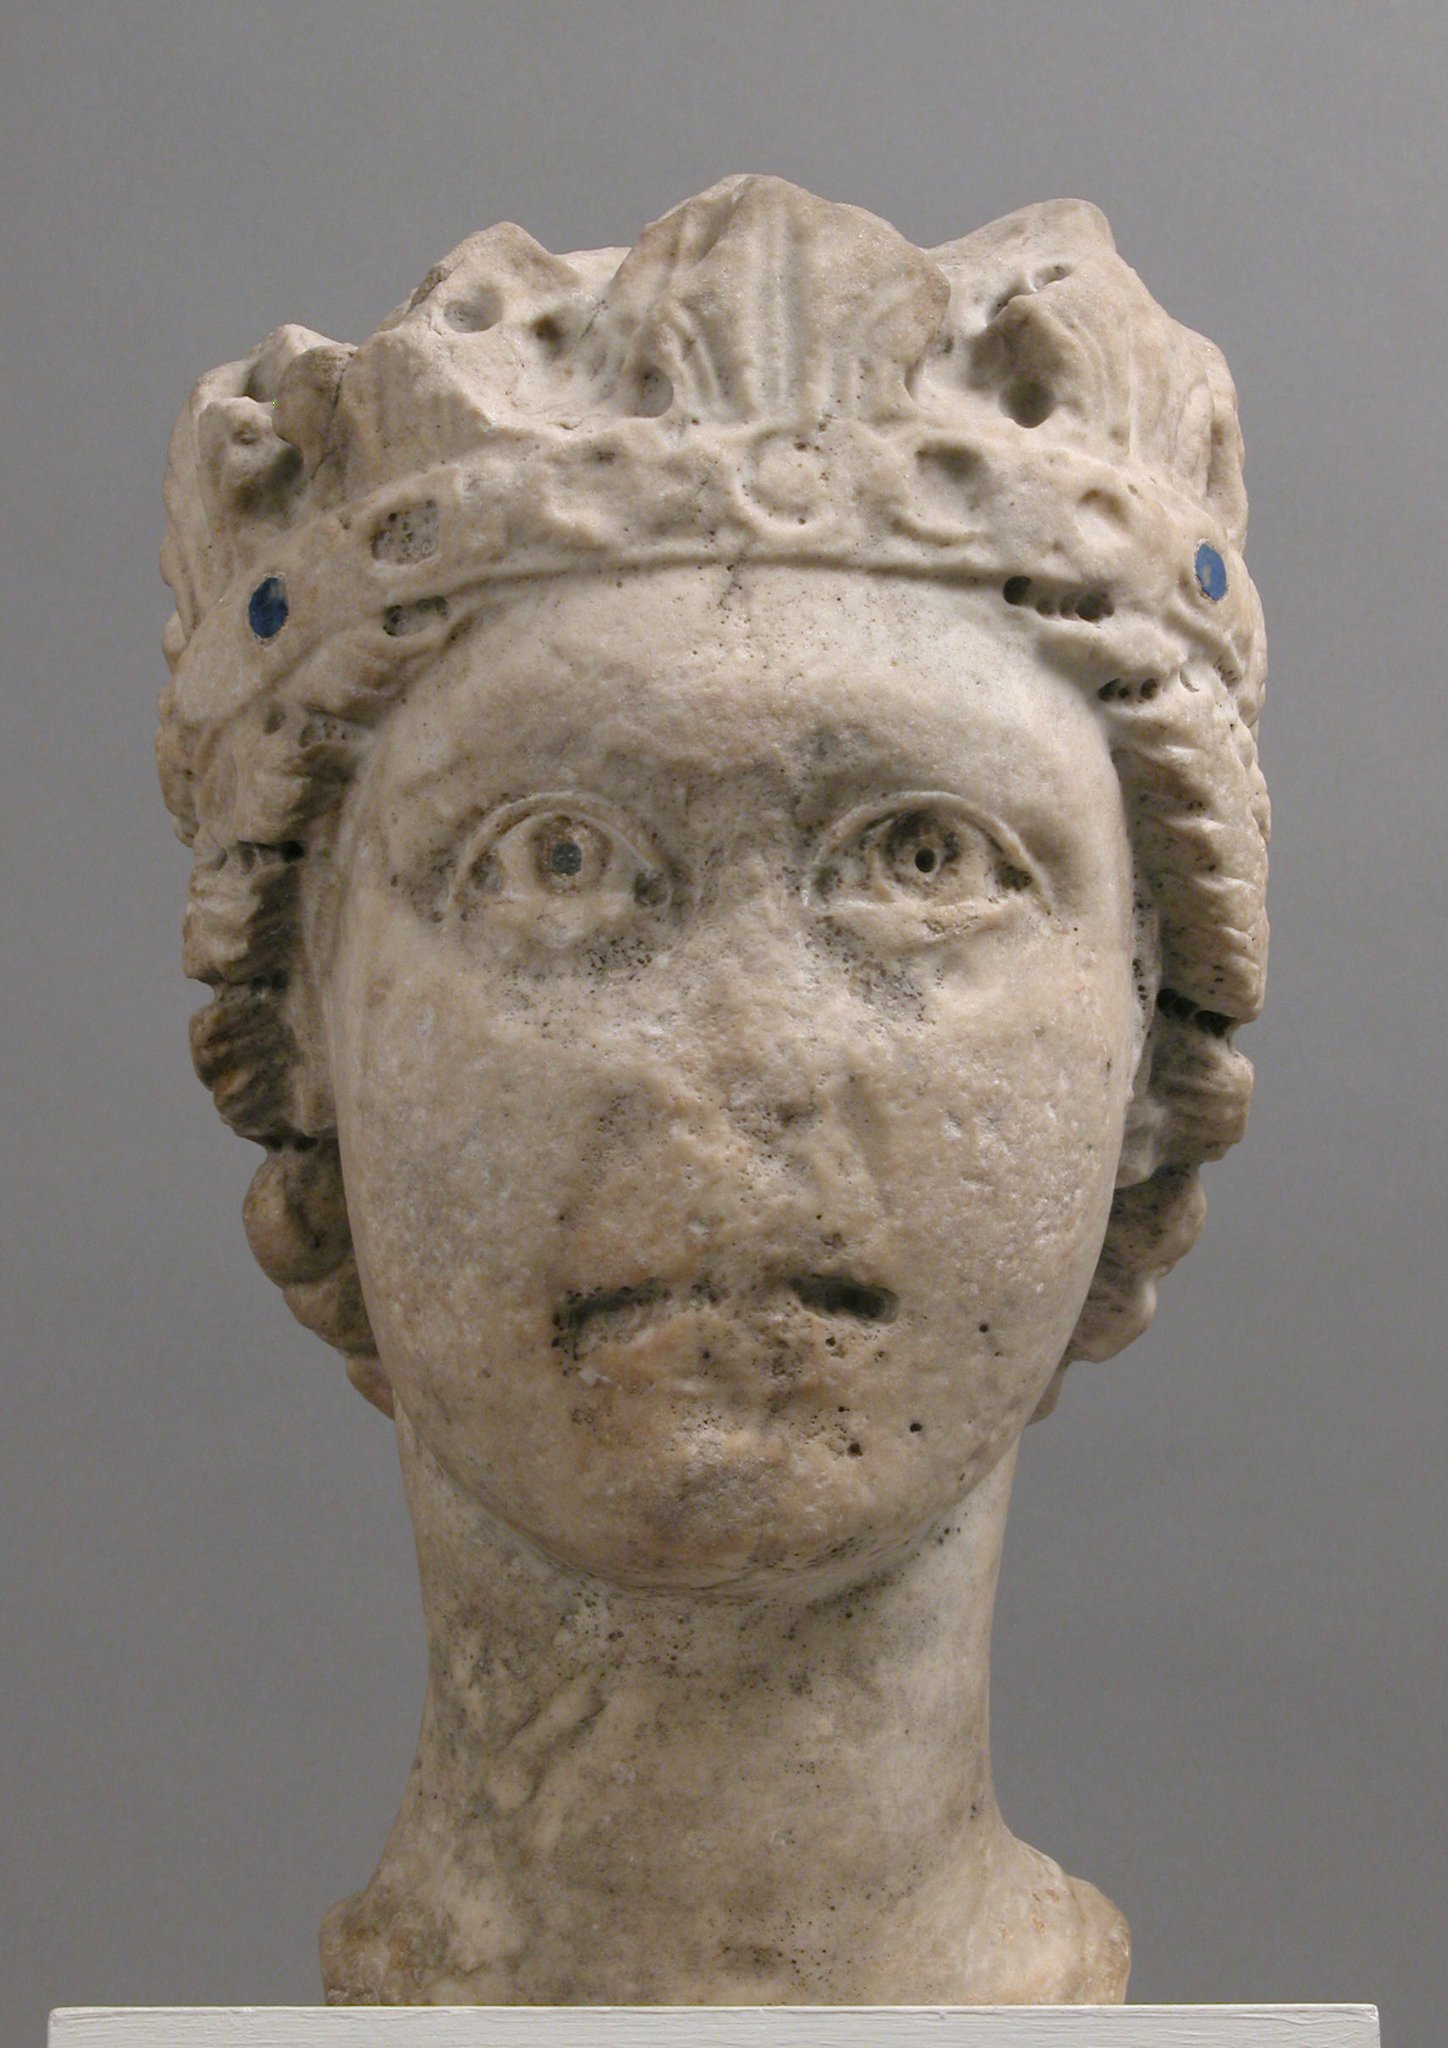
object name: statue head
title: Crowned Head of a Woman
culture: south italian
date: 1270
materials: lapis lazuli, lead, marble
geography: italy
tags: heads